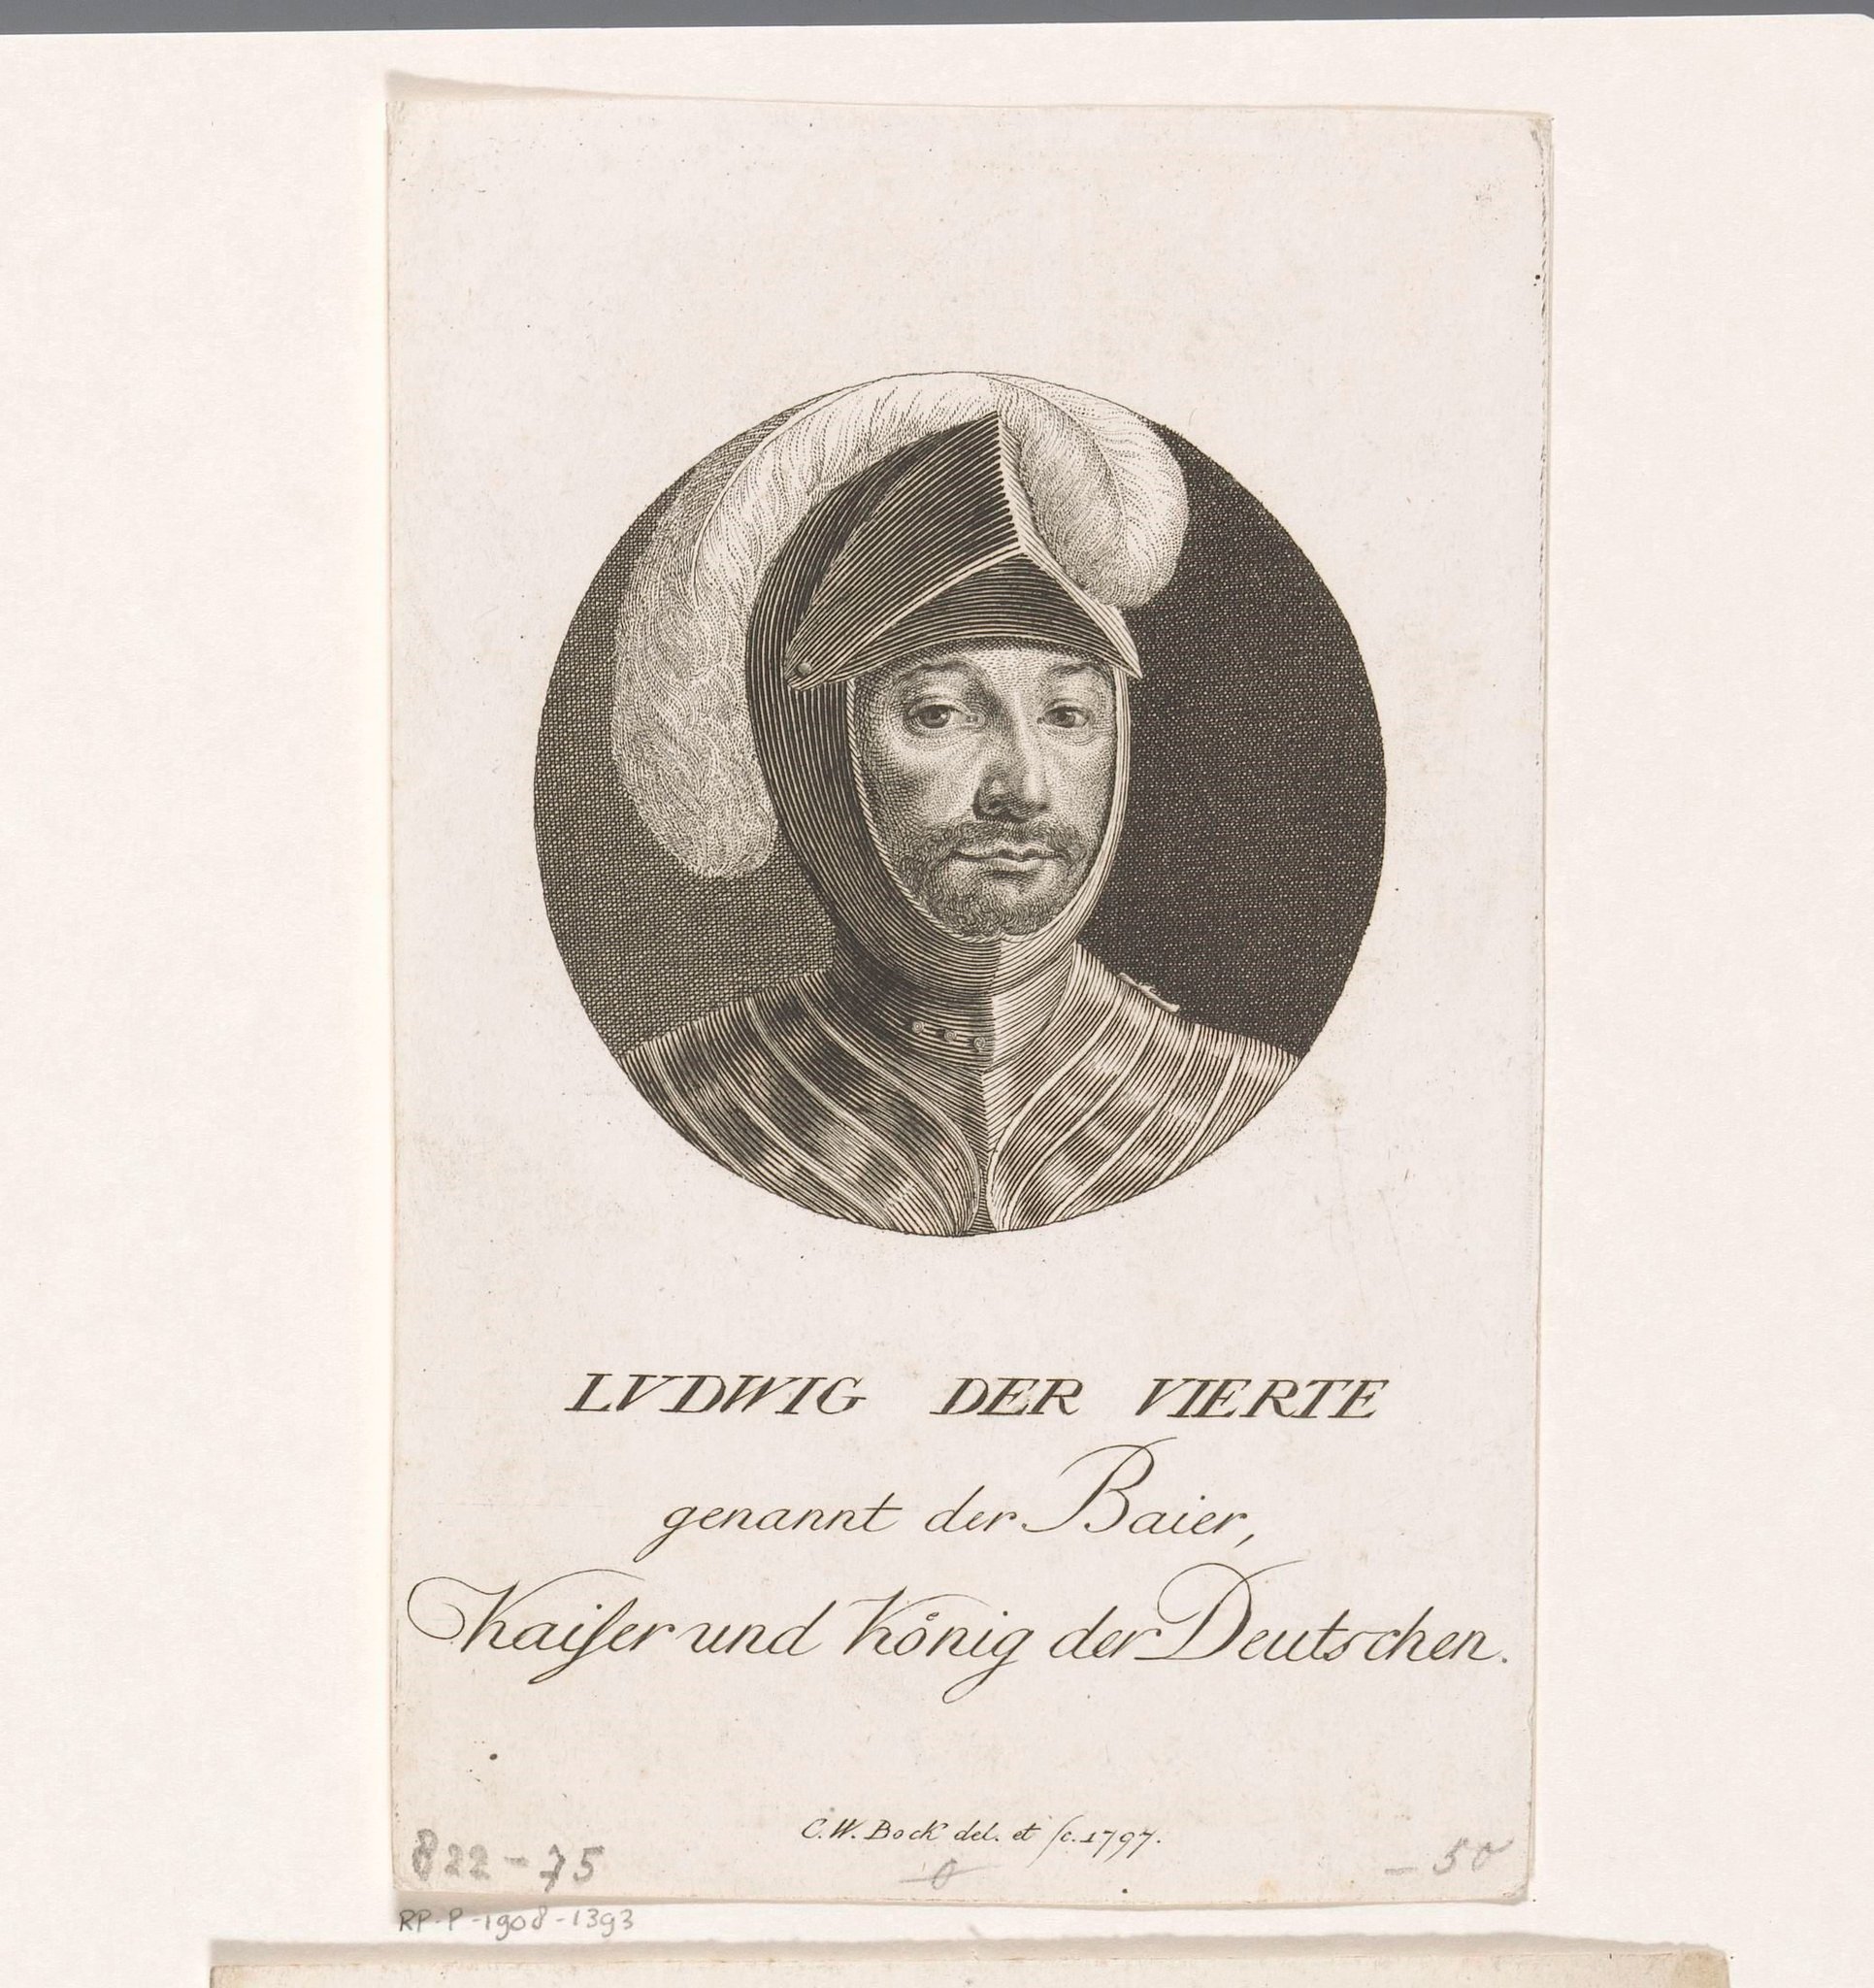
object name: print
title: Portret van keizer Lodewijk de Beier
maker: christoph wilhelm bock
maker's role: print maker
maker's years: 1755-1836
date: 1797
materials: paper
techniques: engraving, etching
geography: nuremberg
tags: armour, historical persons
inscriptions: collector's mark: Lugt 2228